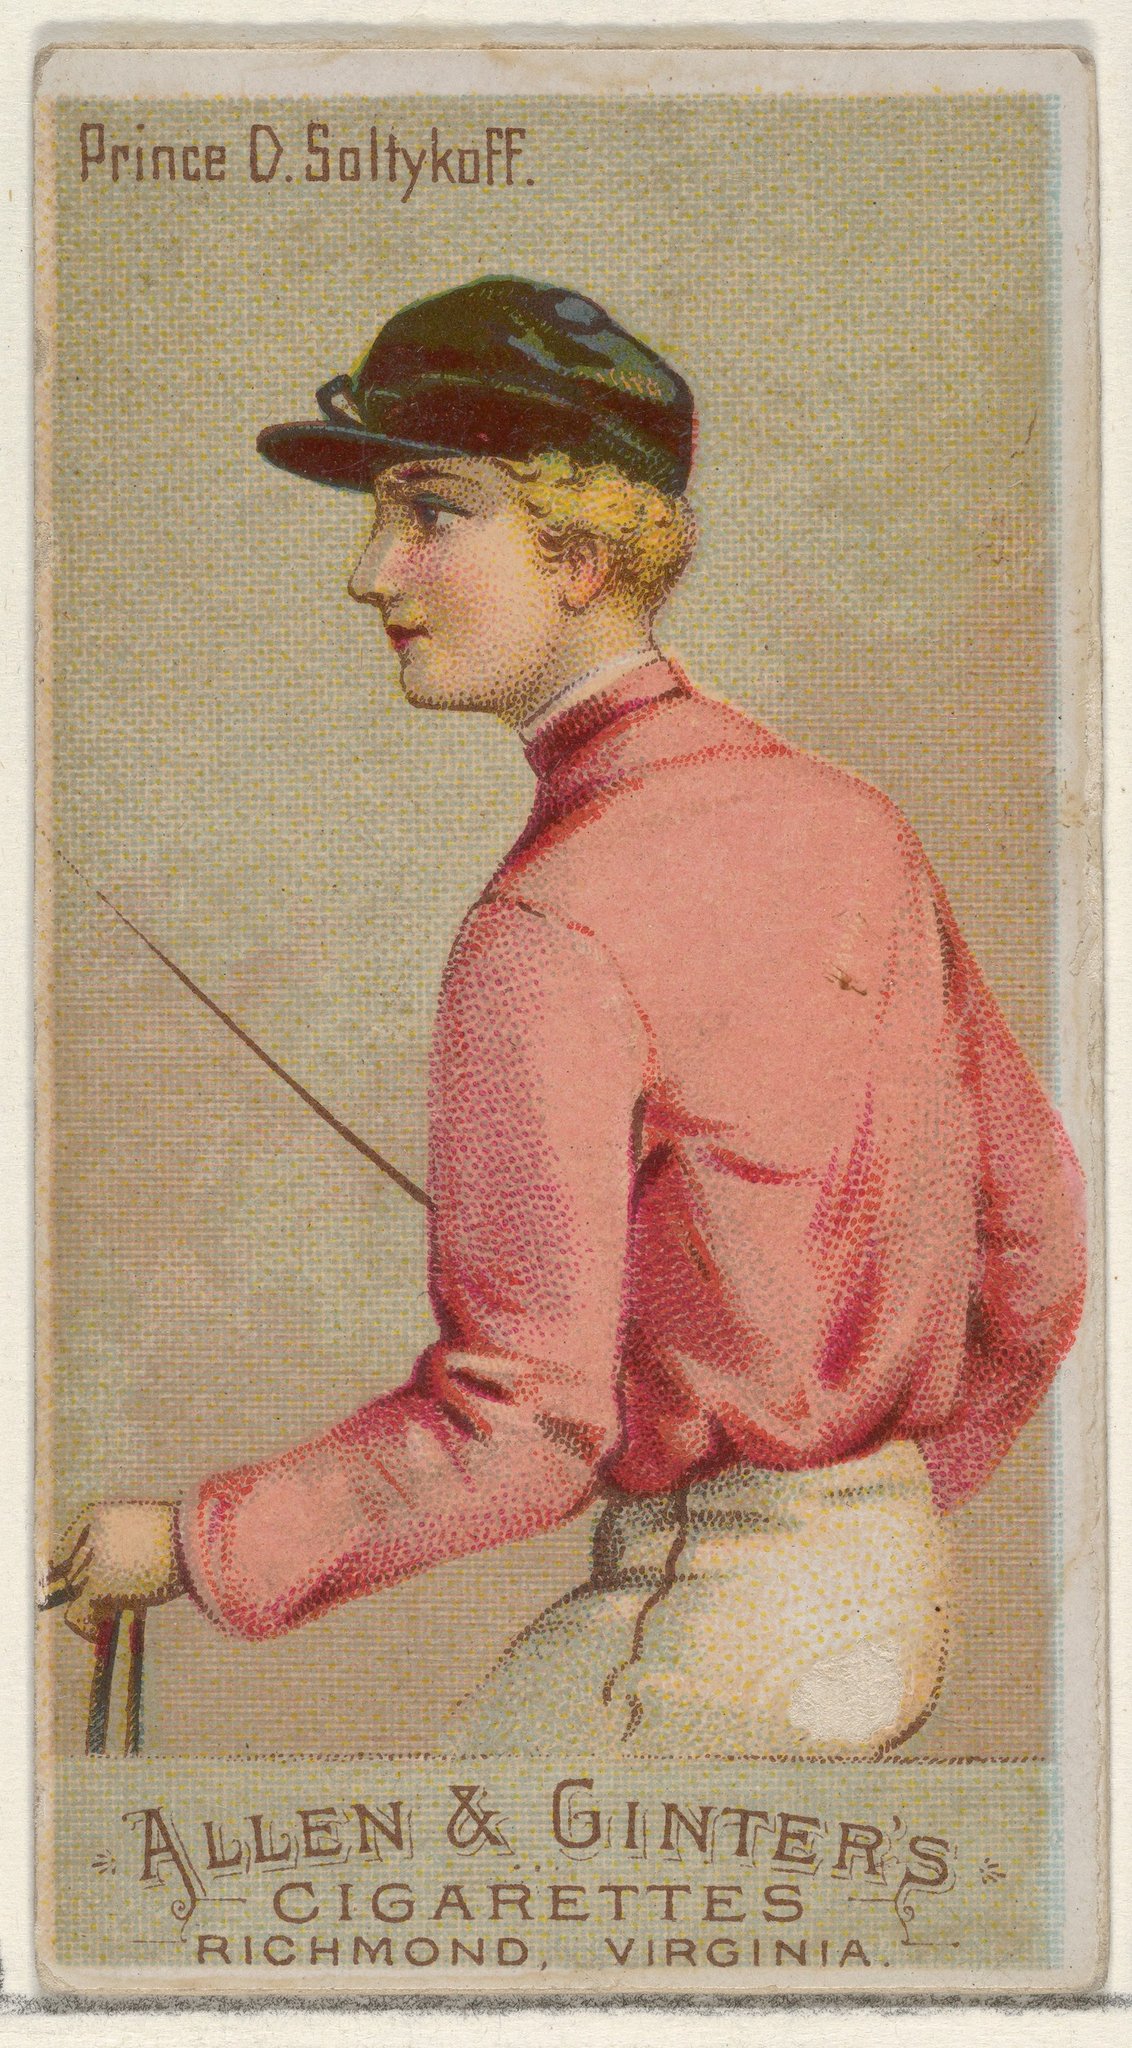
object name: print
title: Prince D. Saltykoff, from the Racing Colors of the World series (N22a) for Allen & Ginter Cigarettes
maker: allen & ginter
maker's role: publisher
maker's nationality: american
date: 1888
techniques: color lithograph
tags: profiles,women,jockeys